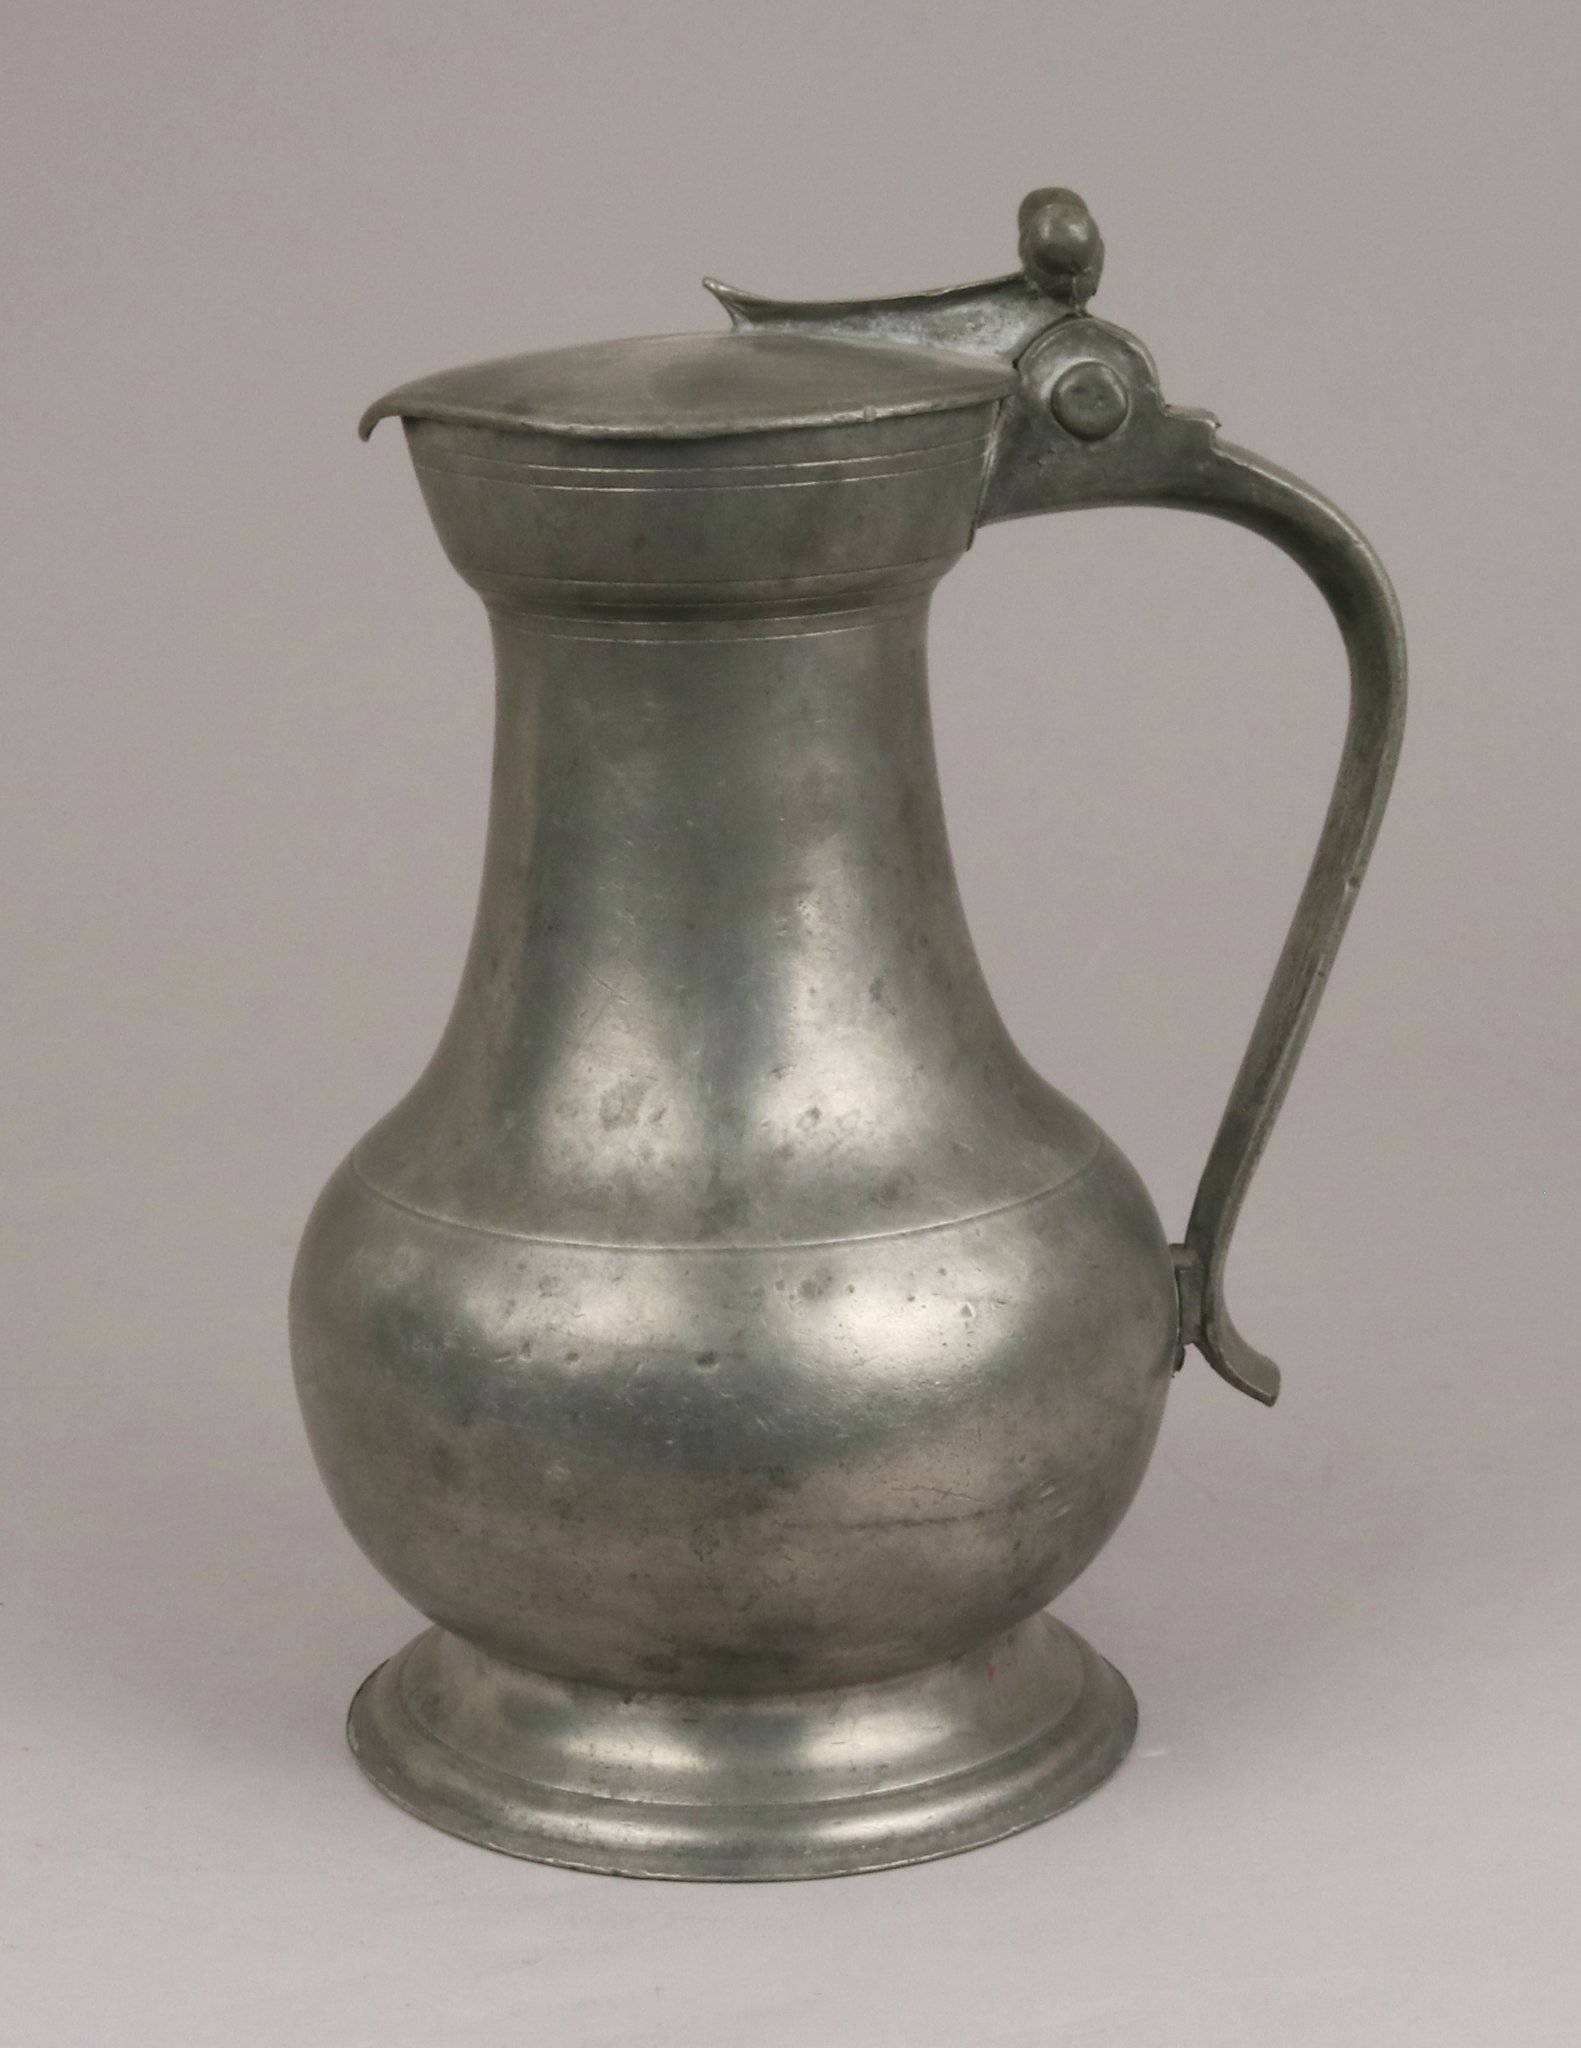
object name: pitcher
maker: c duflos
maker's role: maker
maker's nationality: french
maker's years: 1730-1760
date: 1734-1766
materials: pewter